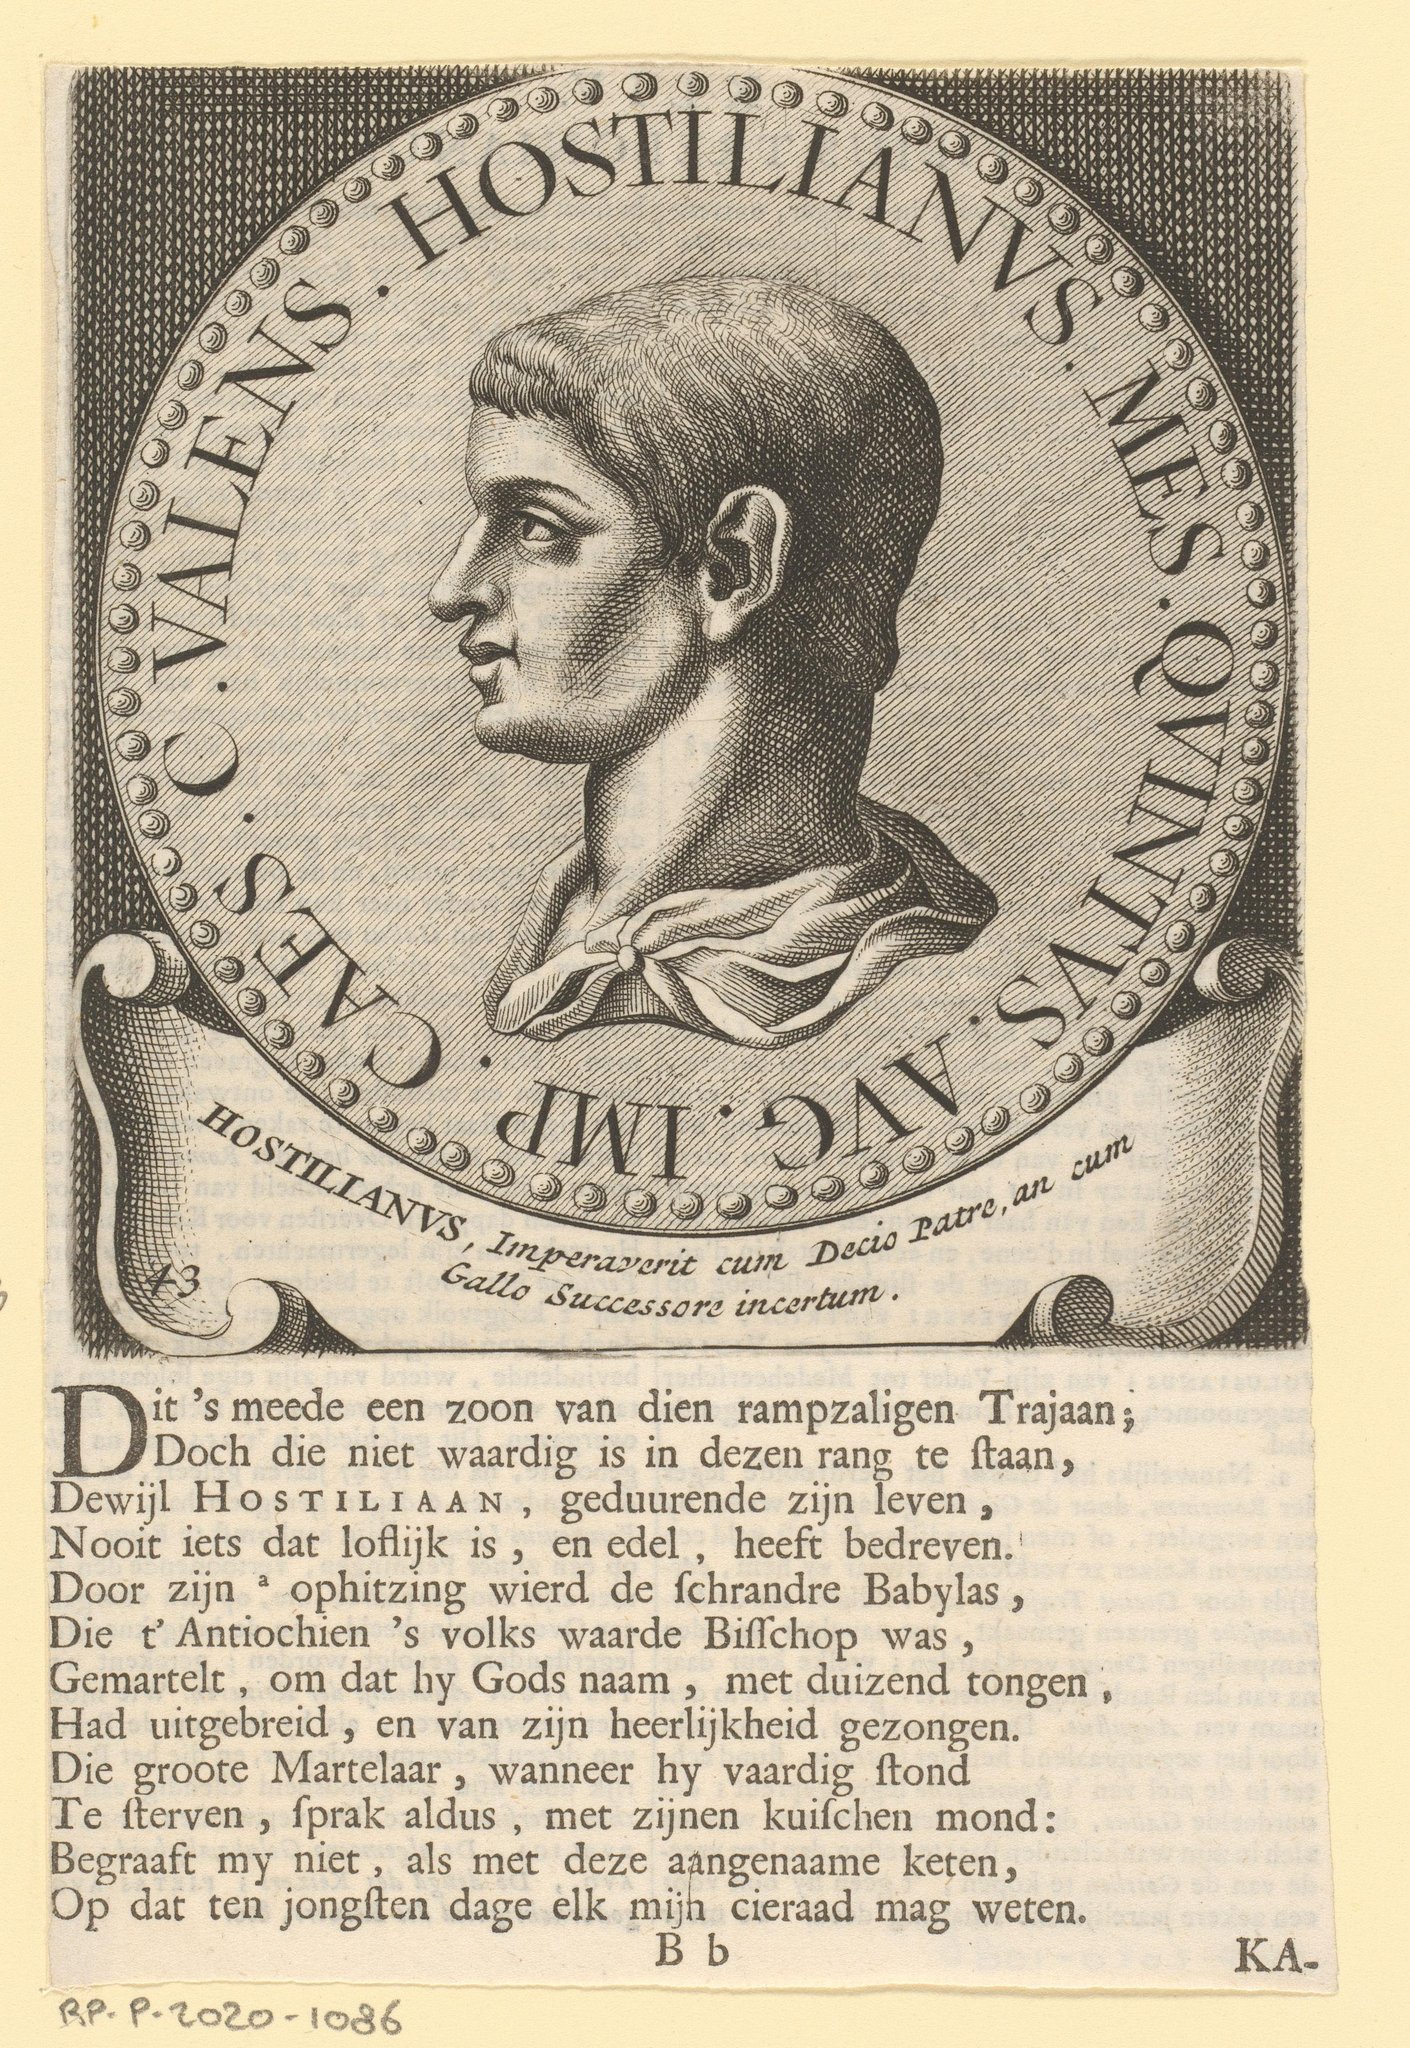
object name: book illustration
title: Portret van keizer Hostilianus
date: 1697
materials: paper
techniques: engraving, etching, letterpress printing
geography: utrecht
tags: historical persons, emperor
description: Prent uit: Bogaert, Abraham. De Roomsche monarchy, vertoont in de muntbeelden der westersche en oostersche keizeren (...). Utrecht: François Halma en Willem van de Water, 1697, p. 193. Eerste staat verschenen in een grotere prent met twaalf portretten, gedateerd 1695.